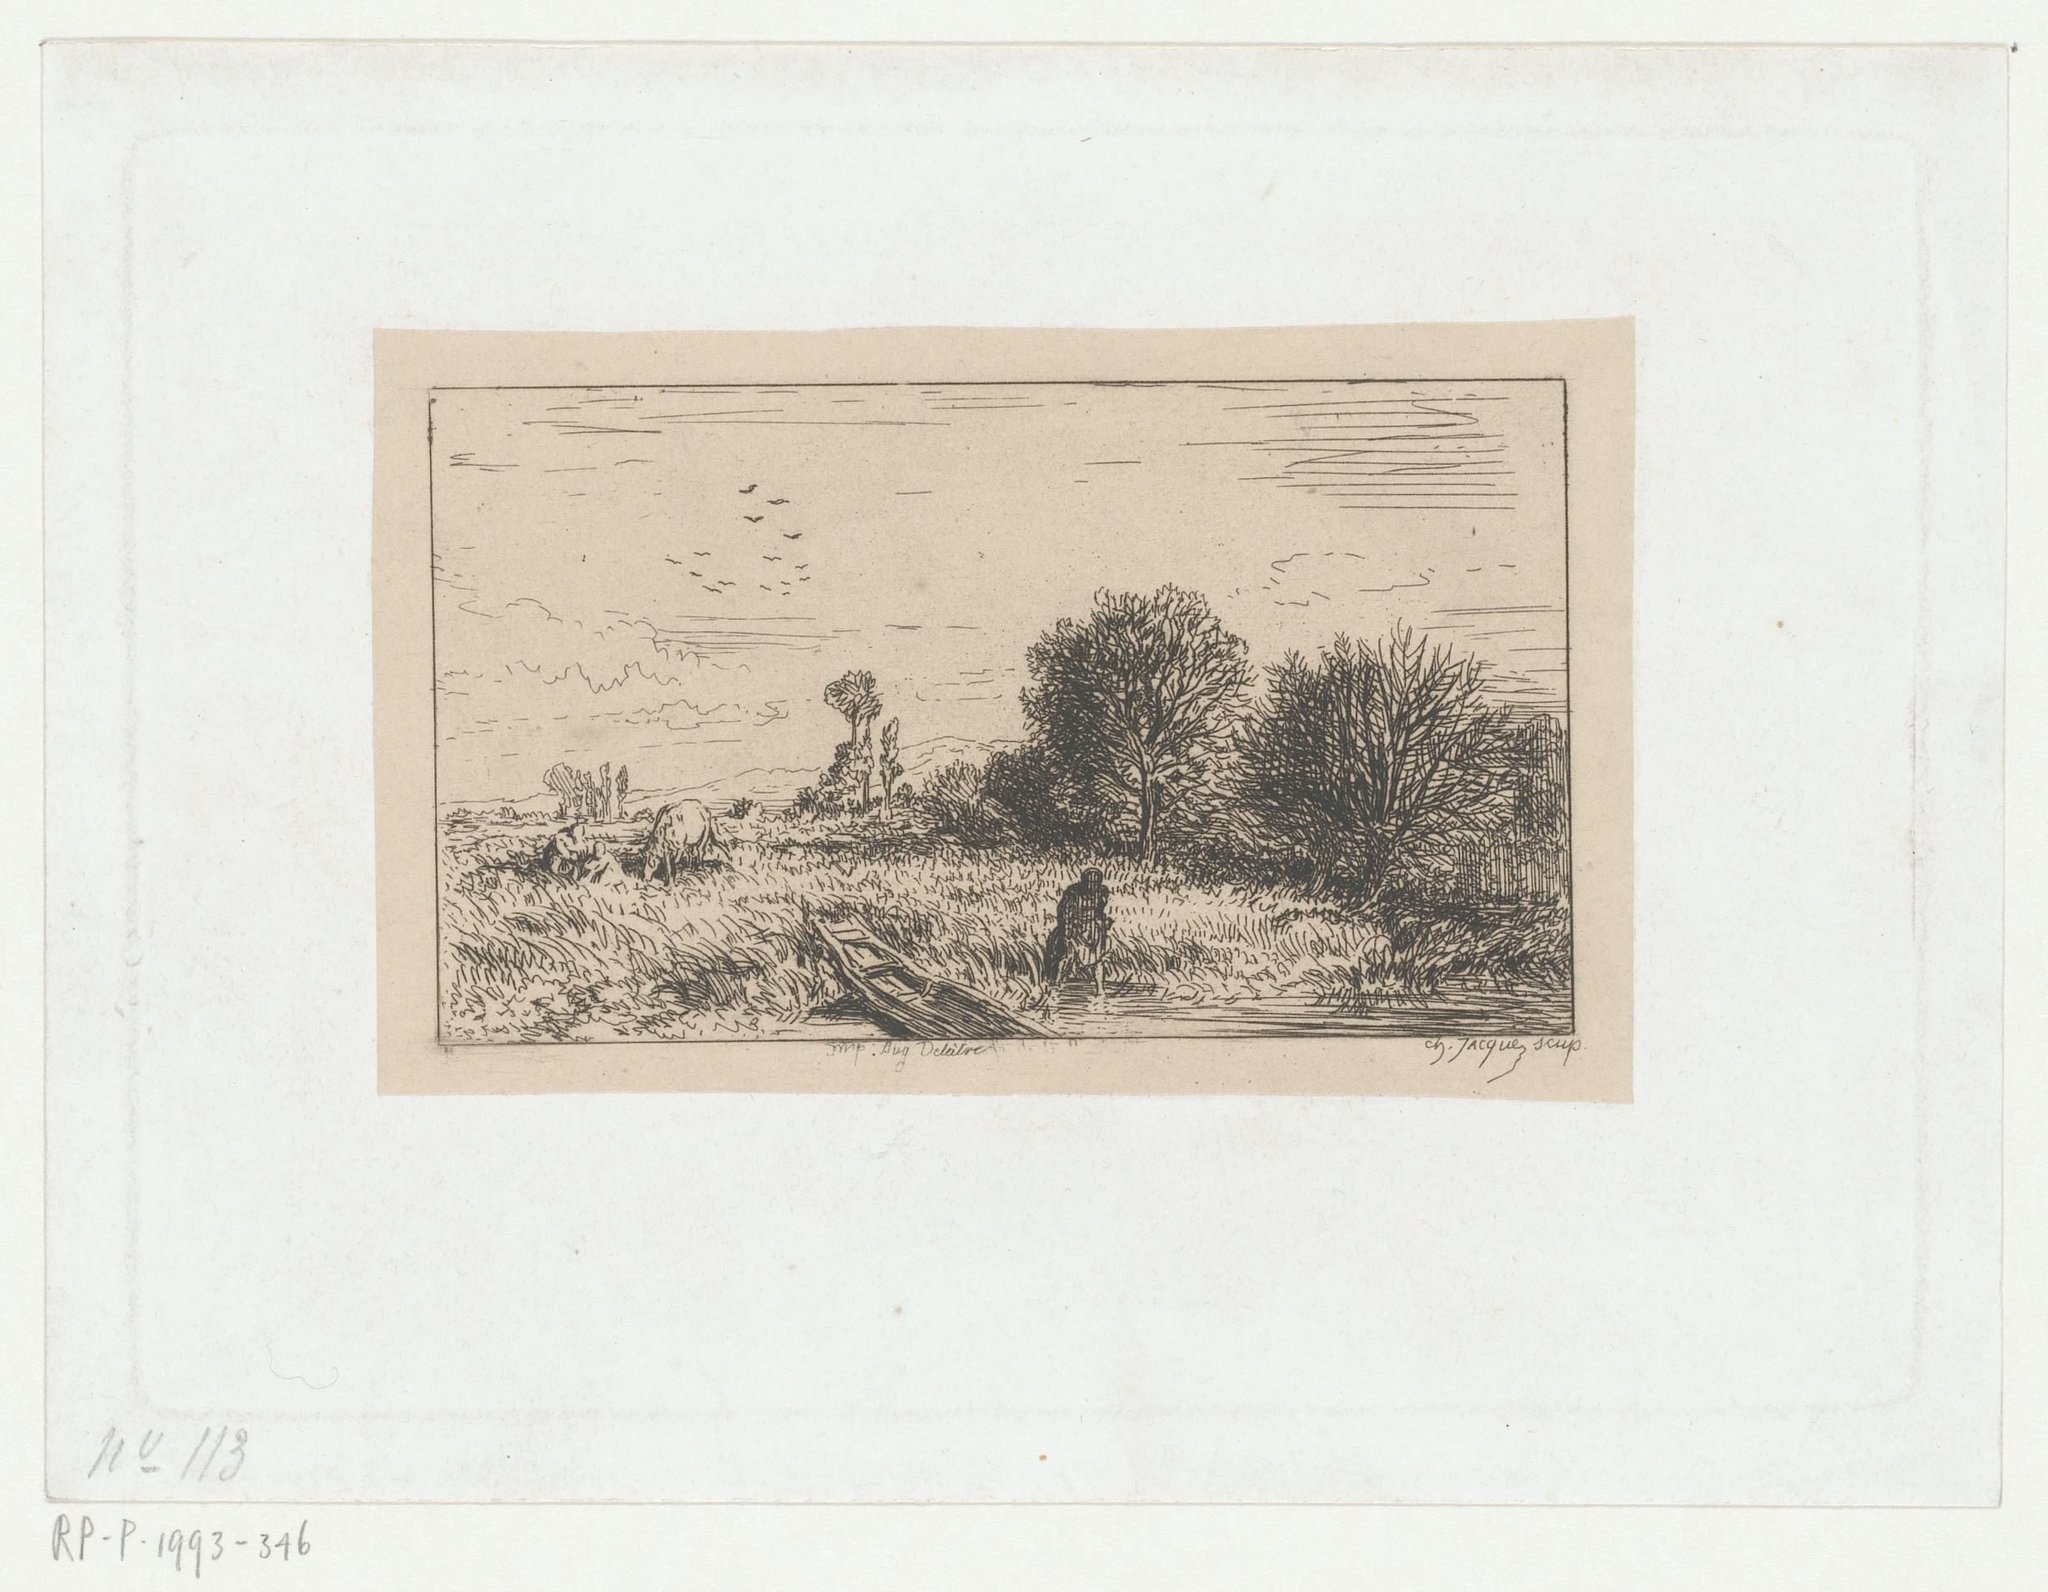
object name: print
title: Landschap met figuur in het water bij een roeiboot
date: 1846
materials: paper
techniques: etching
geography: paris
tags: rowing-boat, canoe, etc., wading, paddling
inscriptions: collector's mark: Lugt 2228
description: Landschap met bomengroep en op de voorgrond een figuur in het water bij een roeiboot. Op de achtergrond twee zittende figuren bij een paard.